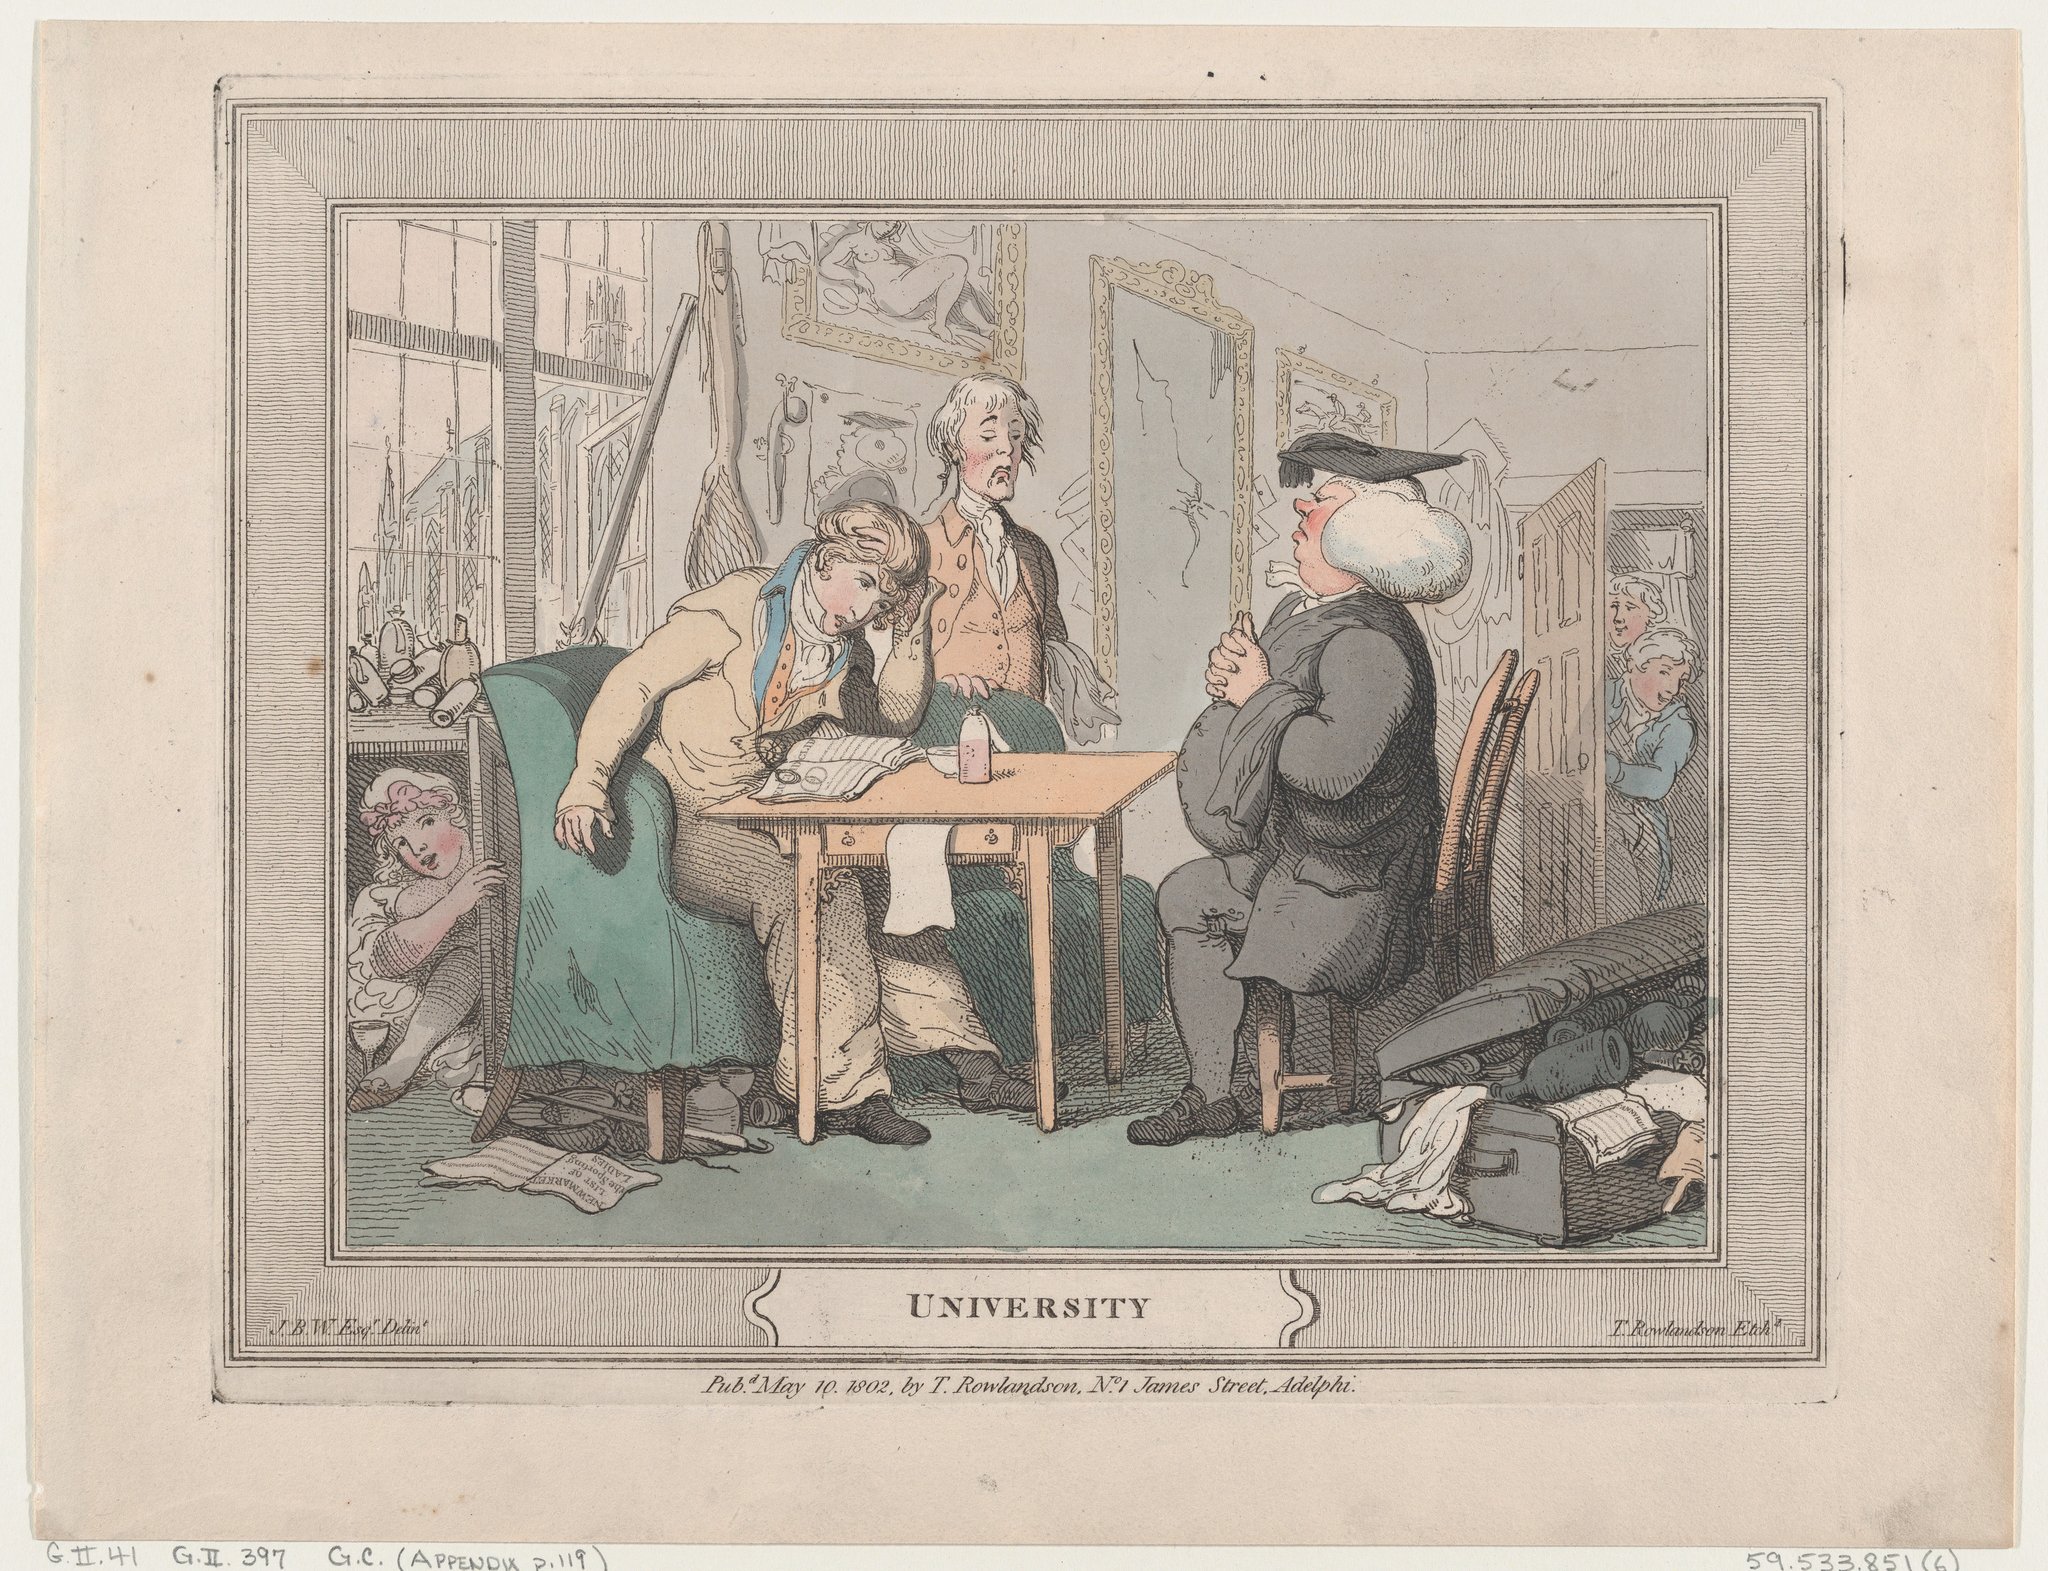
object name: print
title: University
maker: thomas rowlandson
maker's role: artist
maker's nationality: british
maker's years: 1757-1827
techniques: etching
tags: satire,interiors,men,women